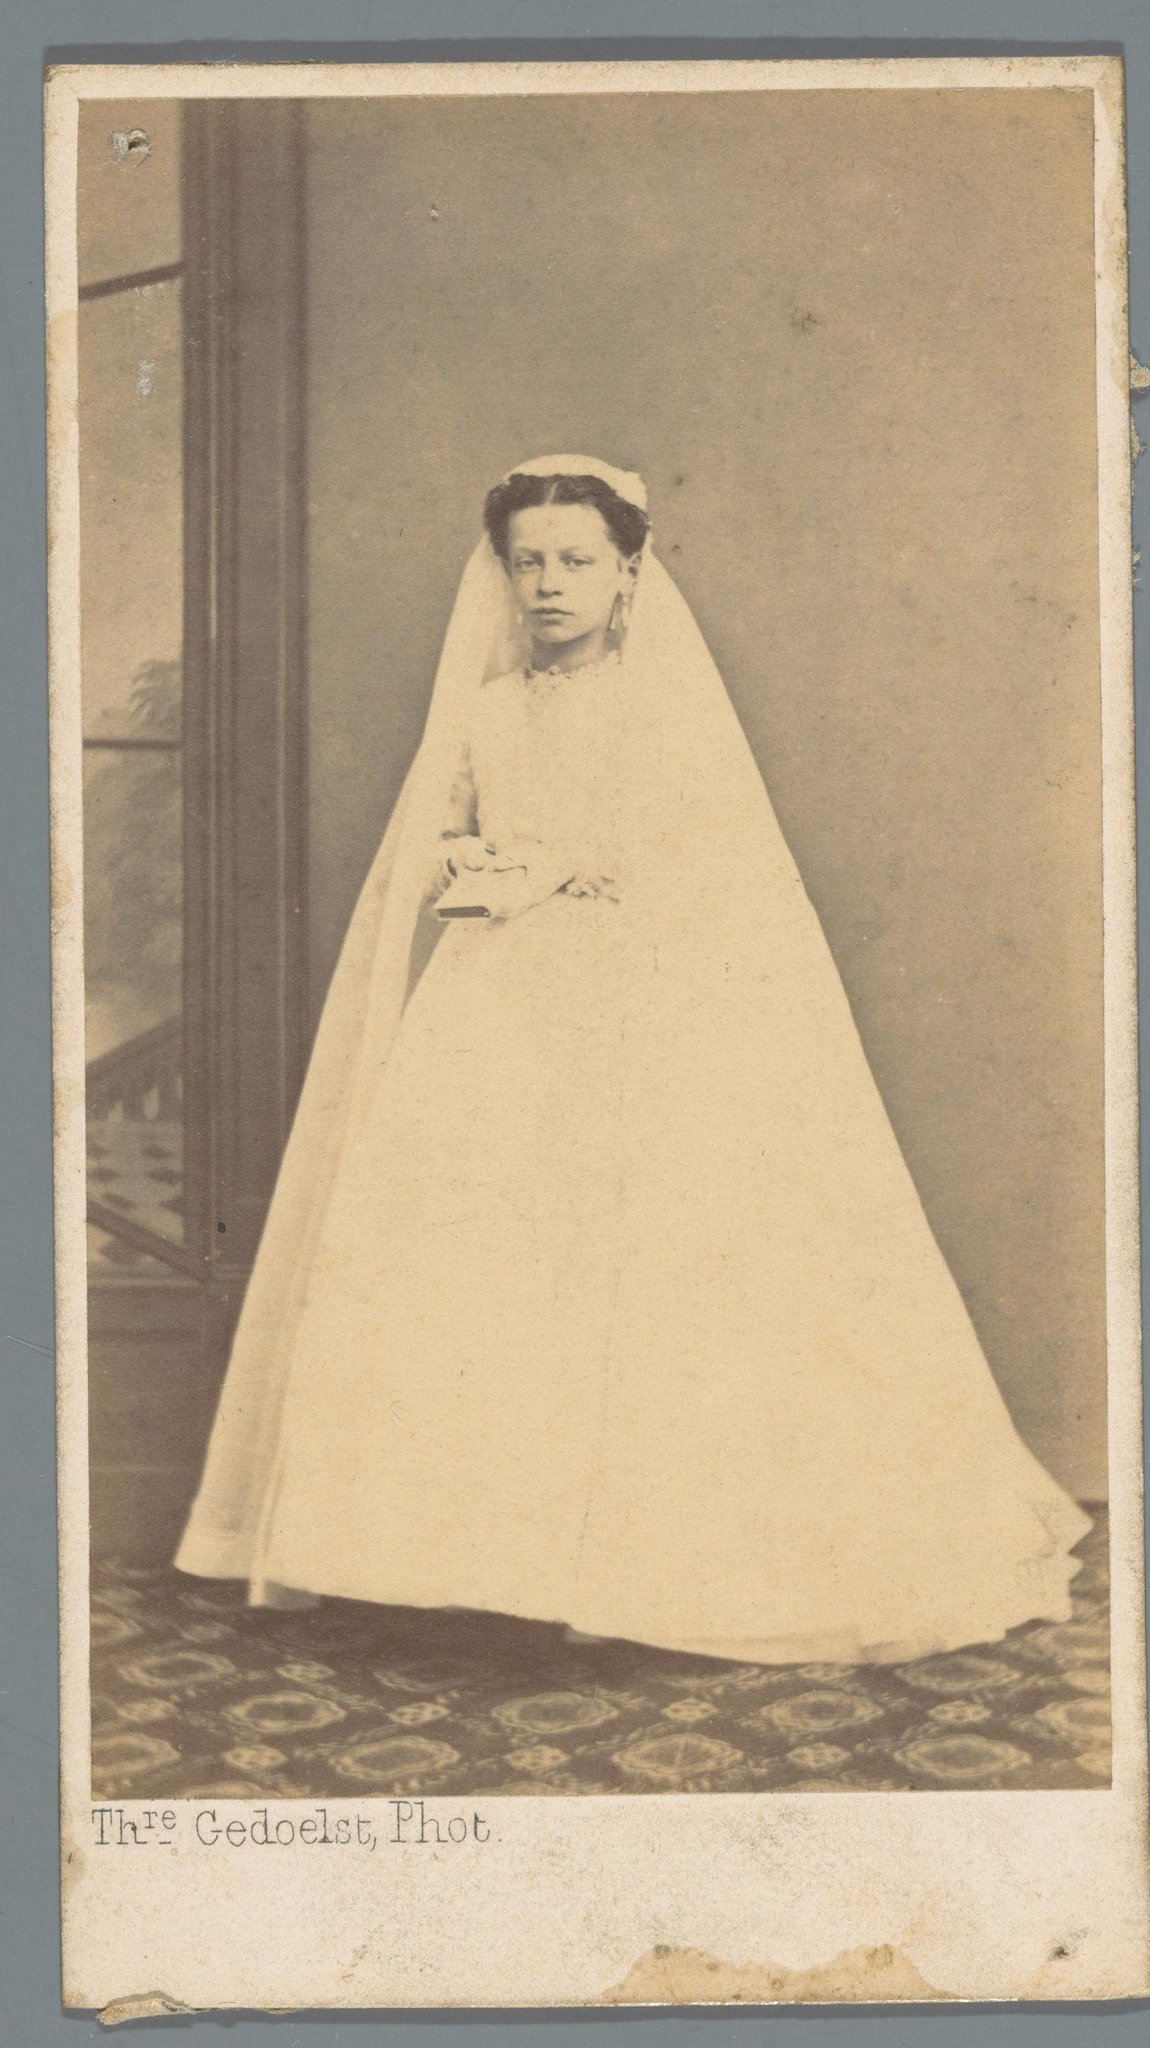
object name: carte de visite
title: Portret van een onbekend meisje in bruidskleding, mogelijk voor de eerste communie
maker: théodore gedoelst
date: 1866-1883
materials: cardboard, paper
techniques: albumen print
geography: leuven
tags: communion dress, child, anonymous historical person portrayed, louvain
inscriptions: inscription: ‘Thre Gedoelst, Phot.’, inscription: ‘Atelier de photographie./ Thre Gedoelst,/ Rue de Namur, 99./ Louvain’